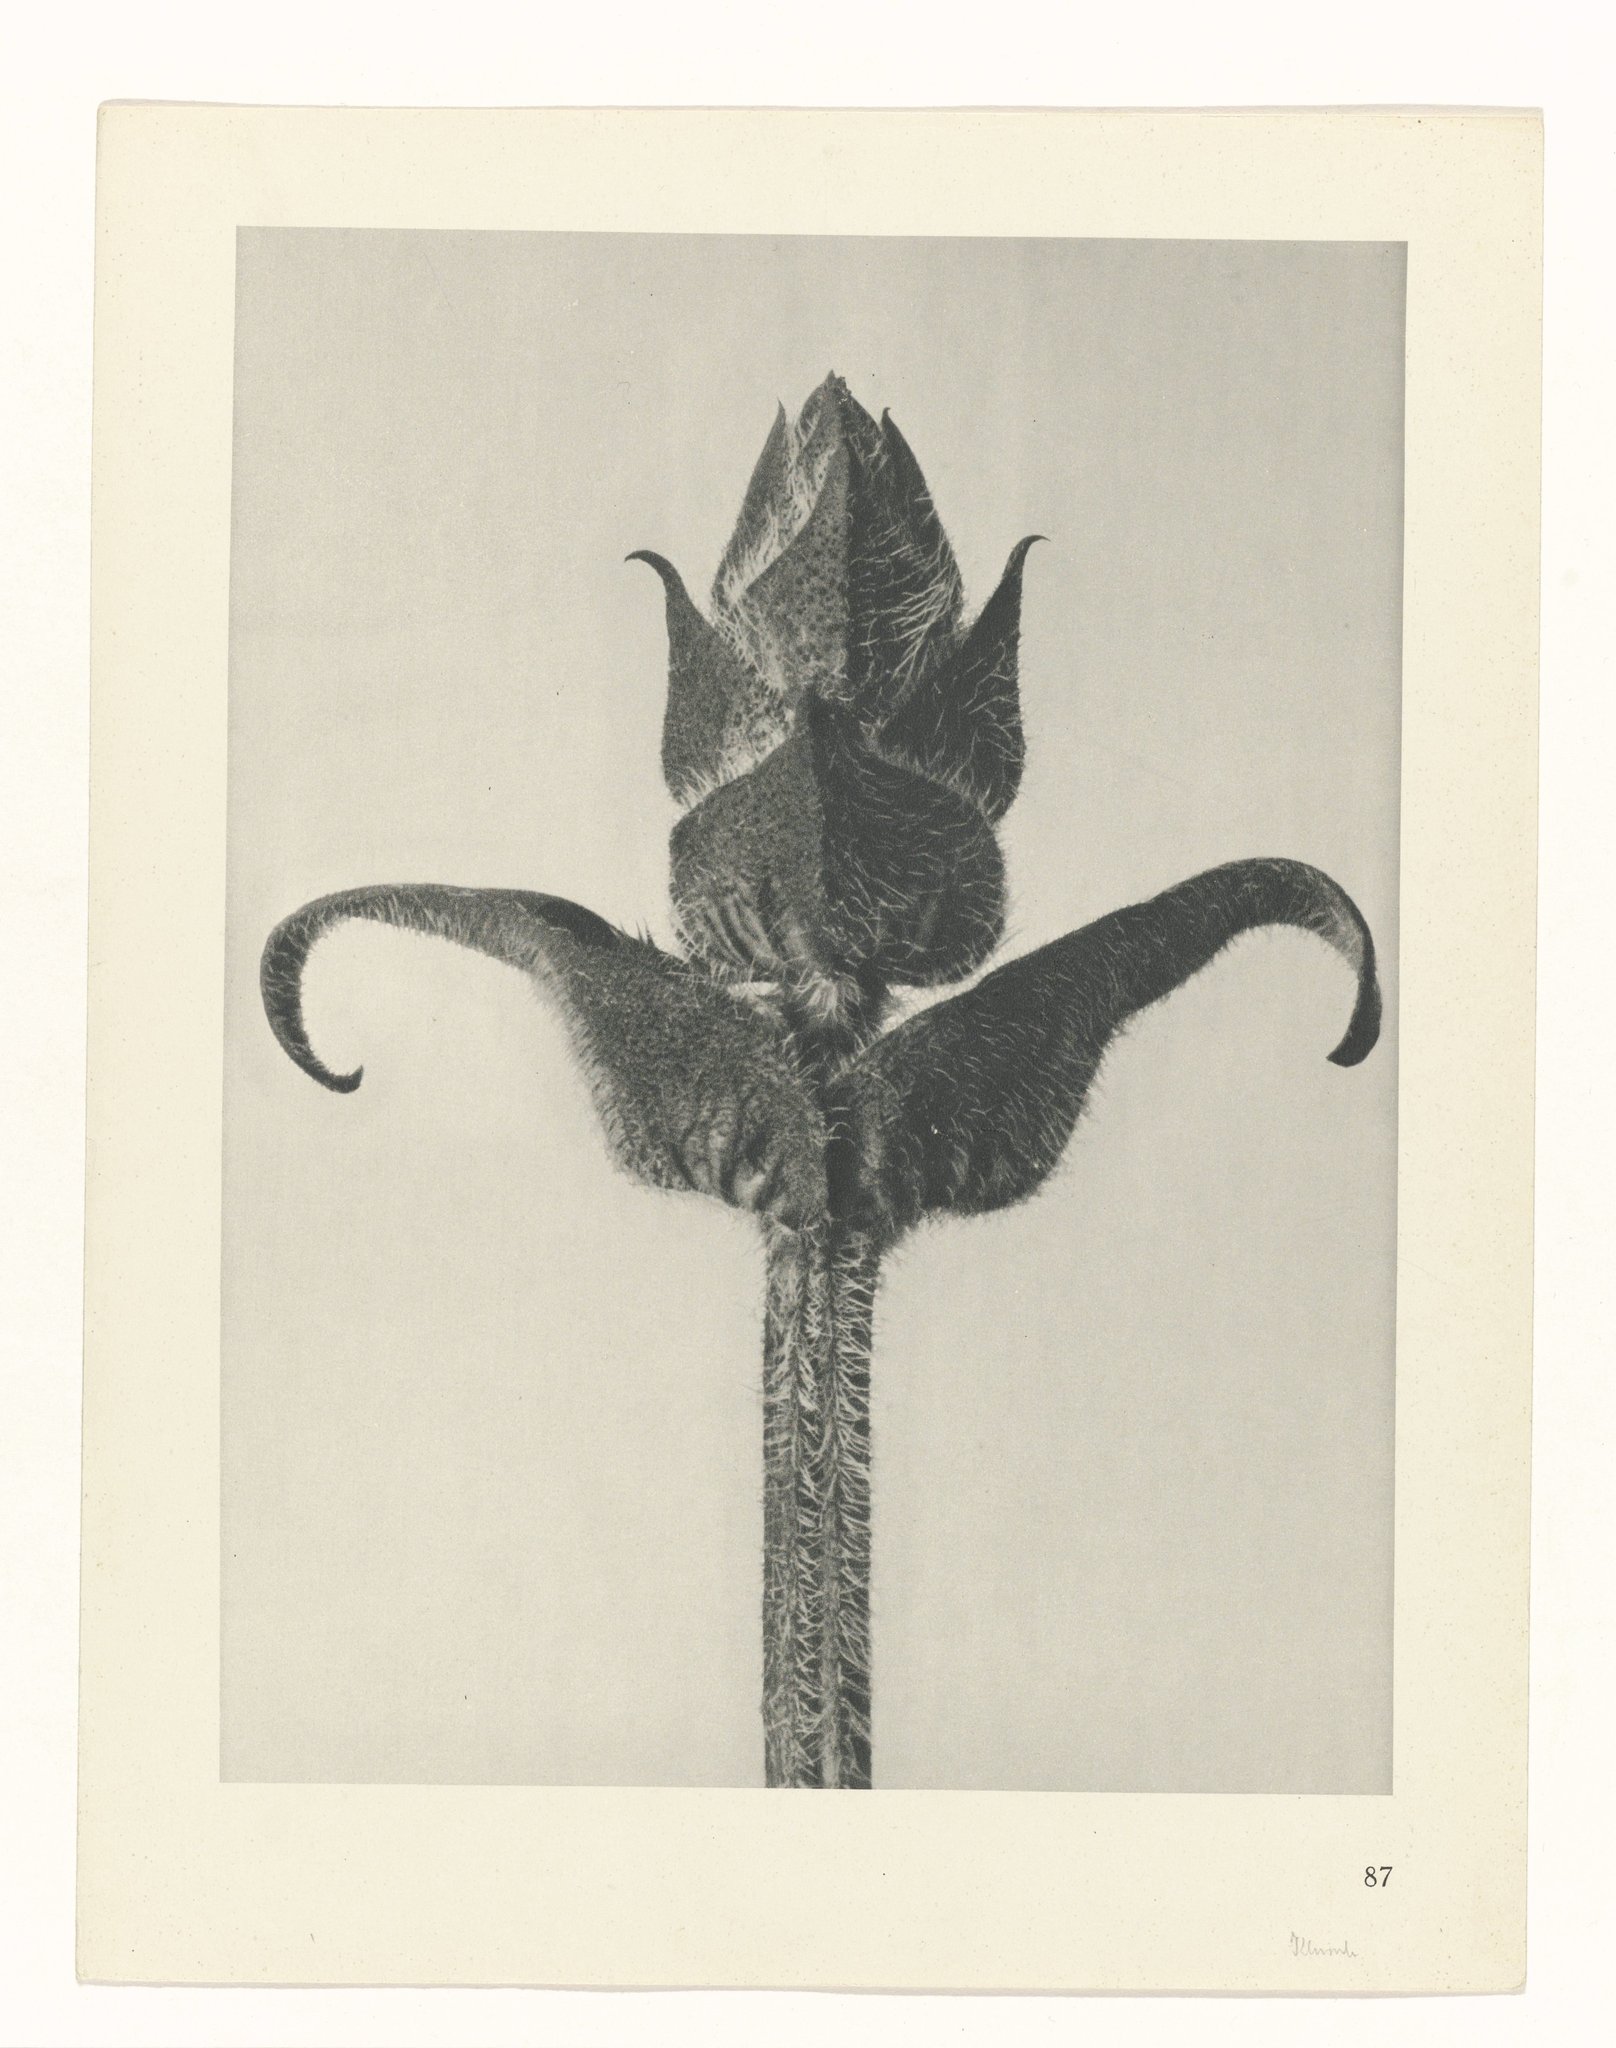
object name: photograph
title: Plantstudie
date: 1928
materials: ink, paper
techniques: rotogravure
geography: berlin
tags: plants (in general)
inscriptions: number: ‘87’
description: facher Vergrößerung. Afkomstig uit losbladige uitgave.